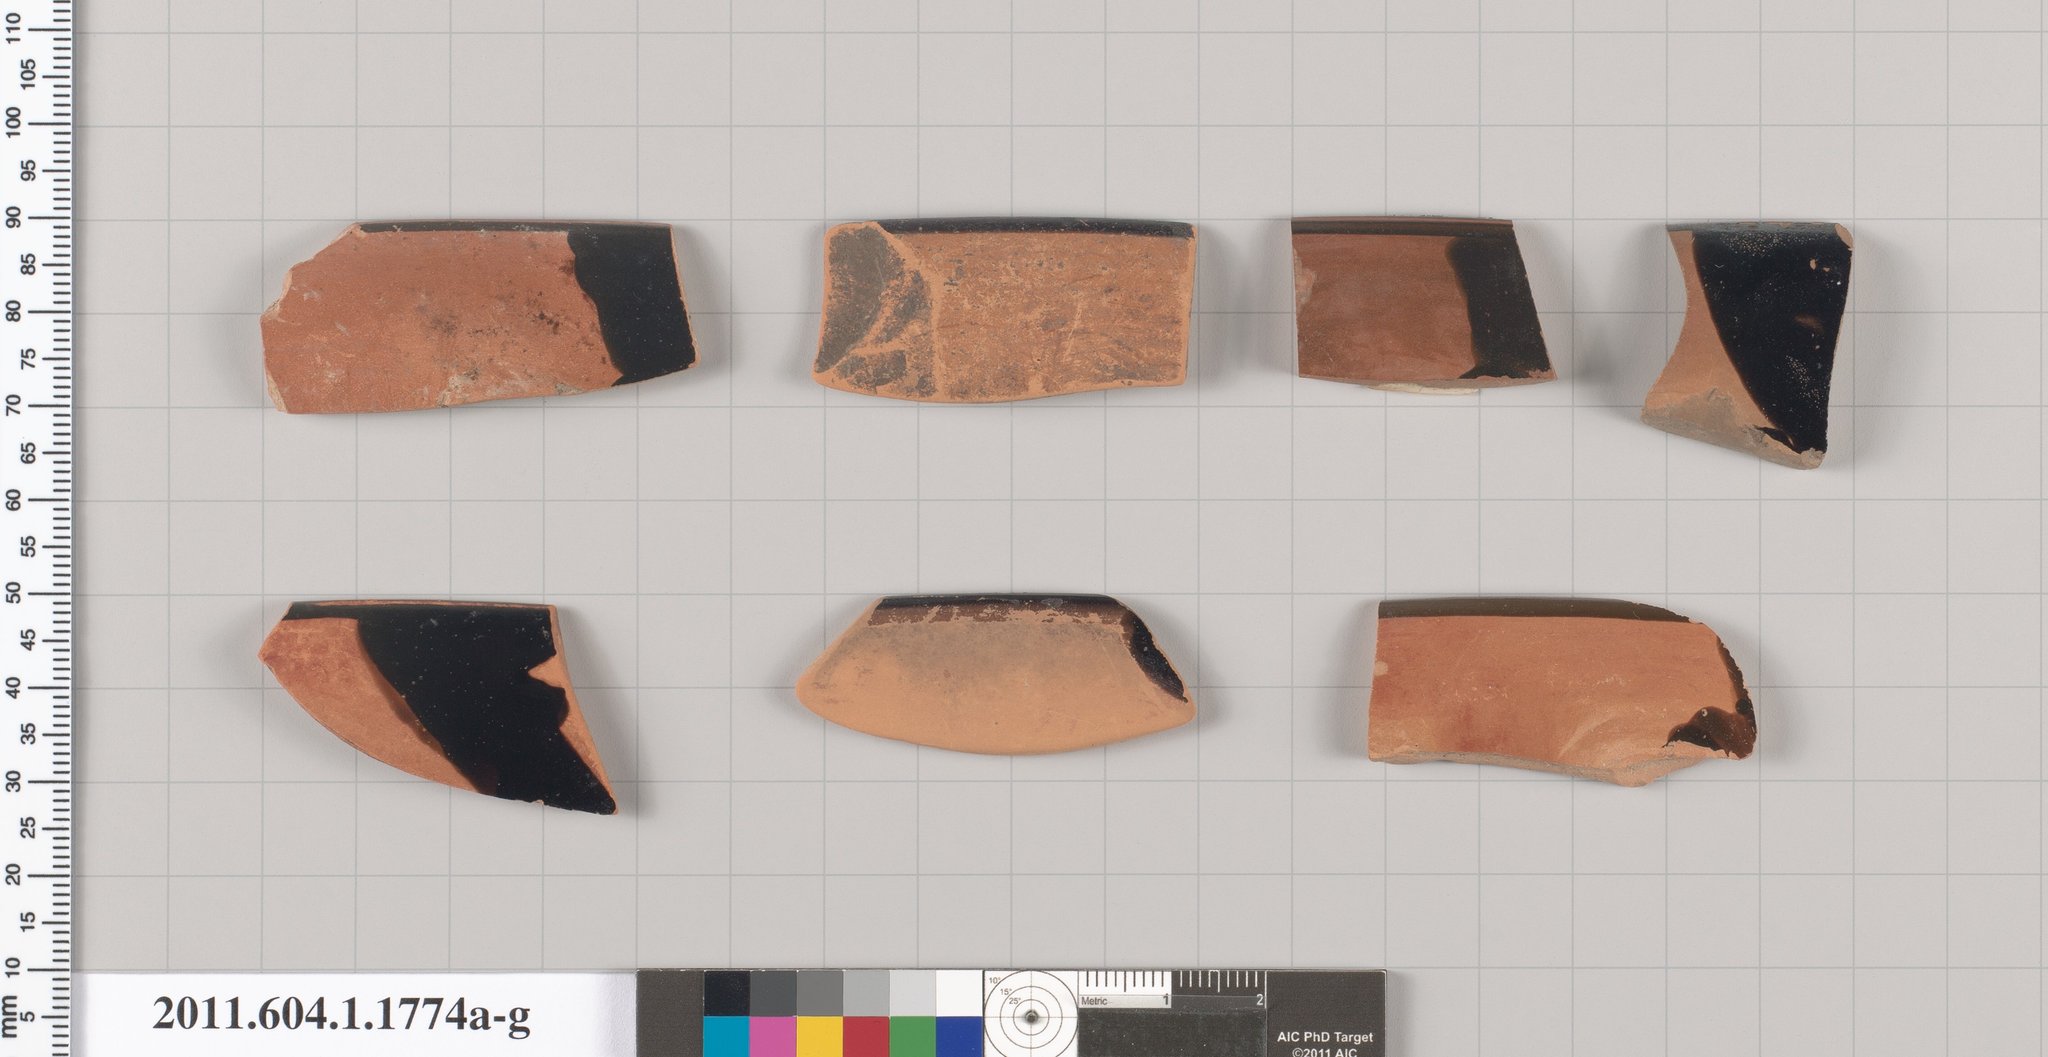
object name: kylix fragment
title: Terracotta rim fragments of kylikes(drinking cups)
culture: greek, attic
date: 500-401 BCE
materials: terracotta